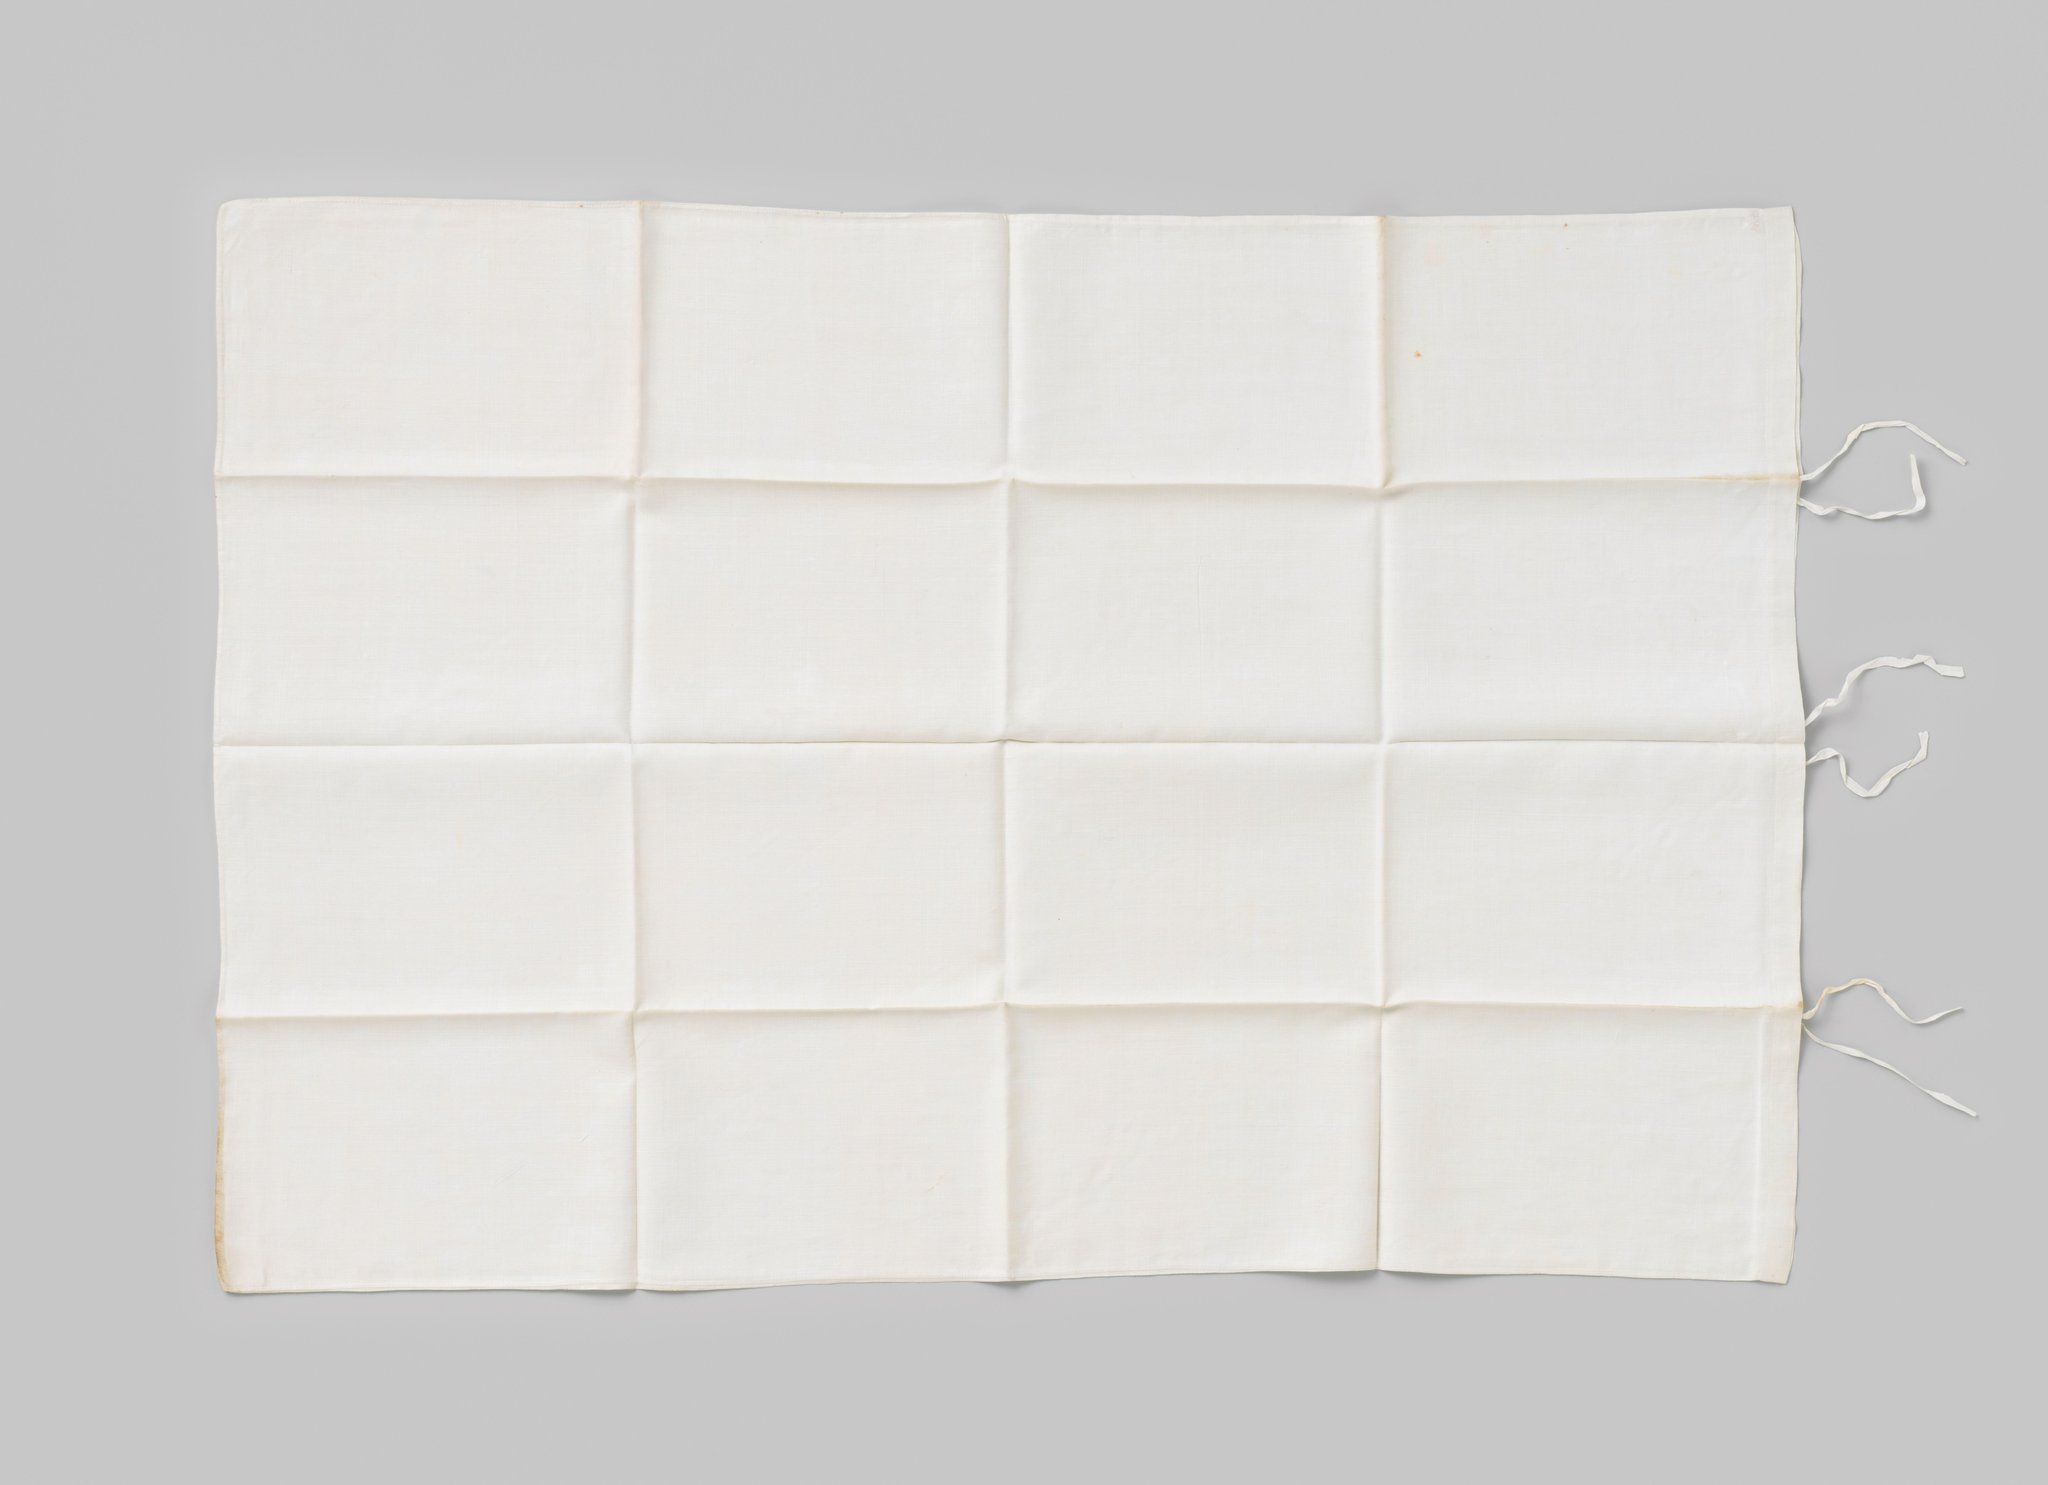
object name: sloop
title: Sloop van linnen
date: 1820-1870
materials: linen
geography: northern netherlands